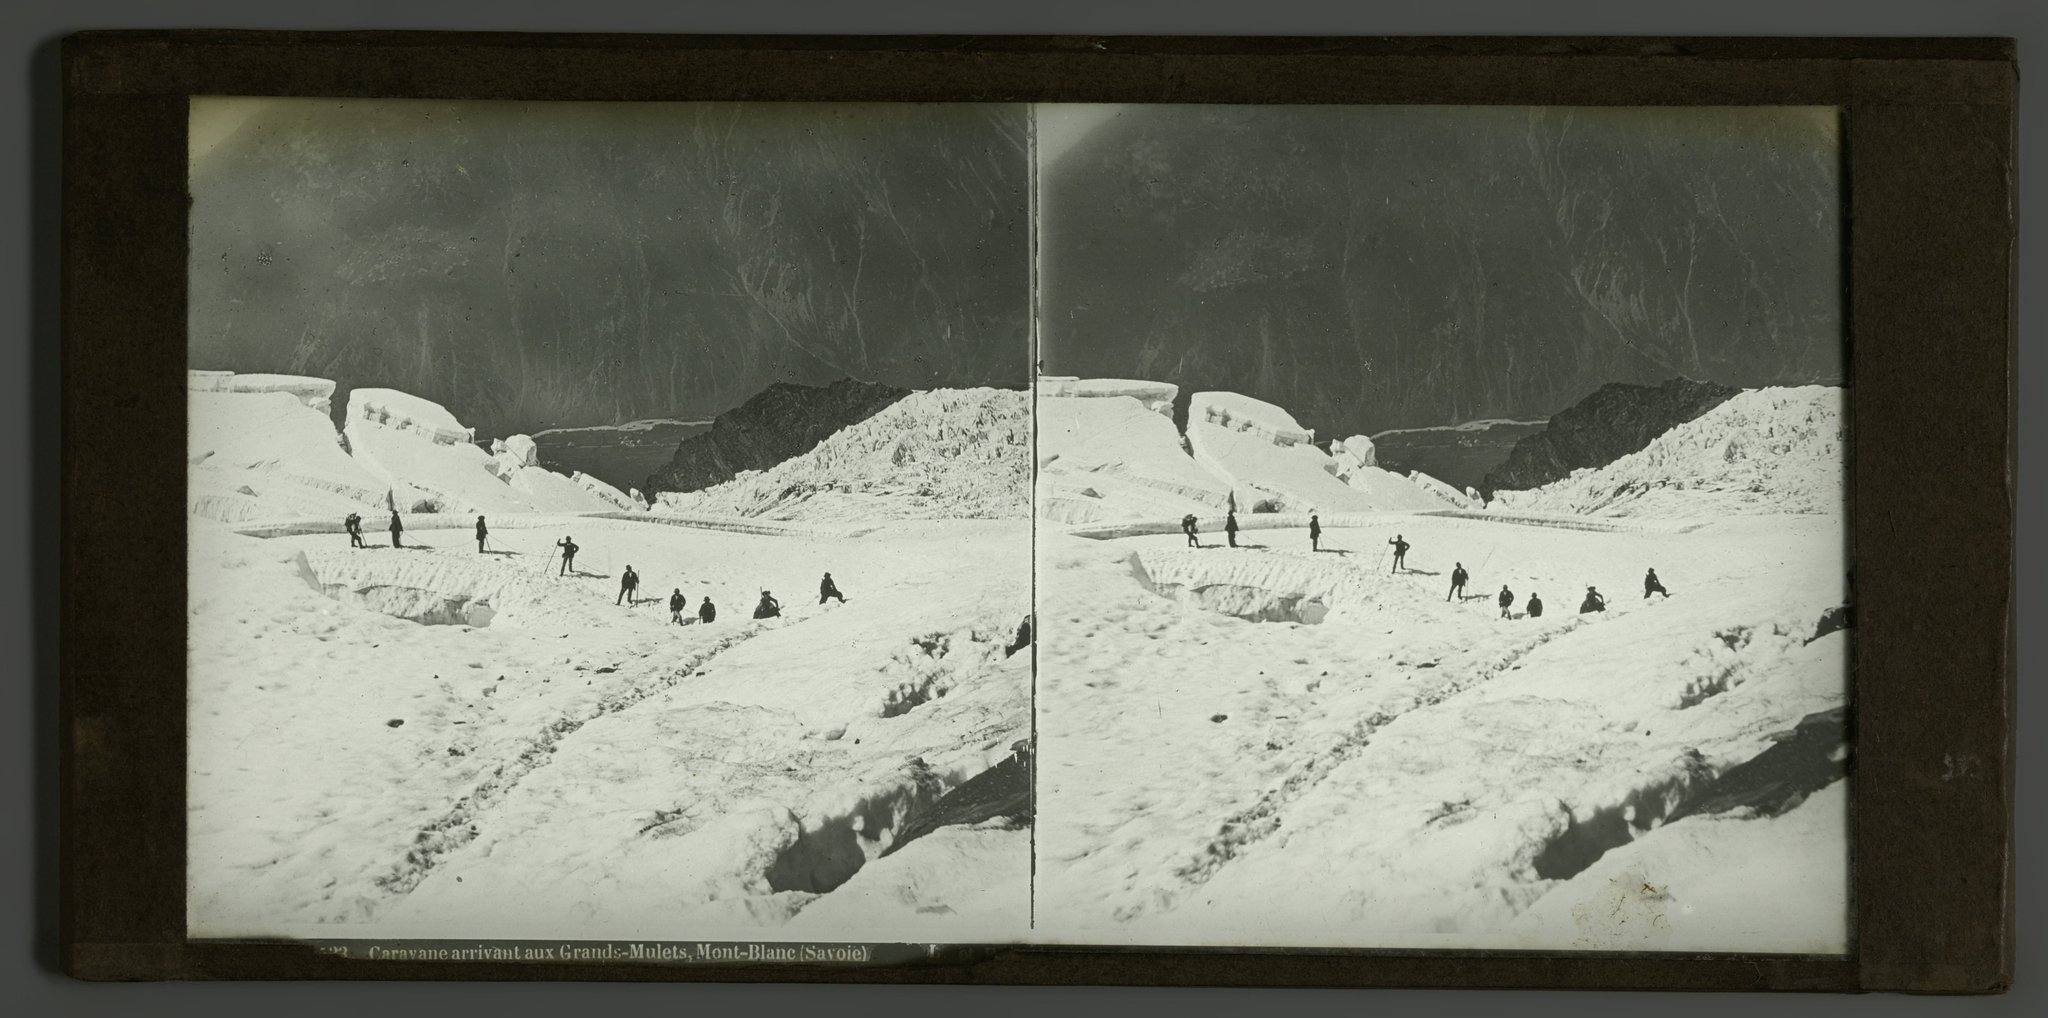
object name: stereoscopic photograph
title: Groep bergbeklimmers komt aan bij Grands-Mulets op de Mont Blanc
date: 1856-1890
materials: glass, paper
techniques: slide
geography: mont blanc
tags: mountain climbing, mountaineering, 'en route', traveller under way (+ four persons or more ~ traffic and transport)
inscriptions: number: ‘4533’